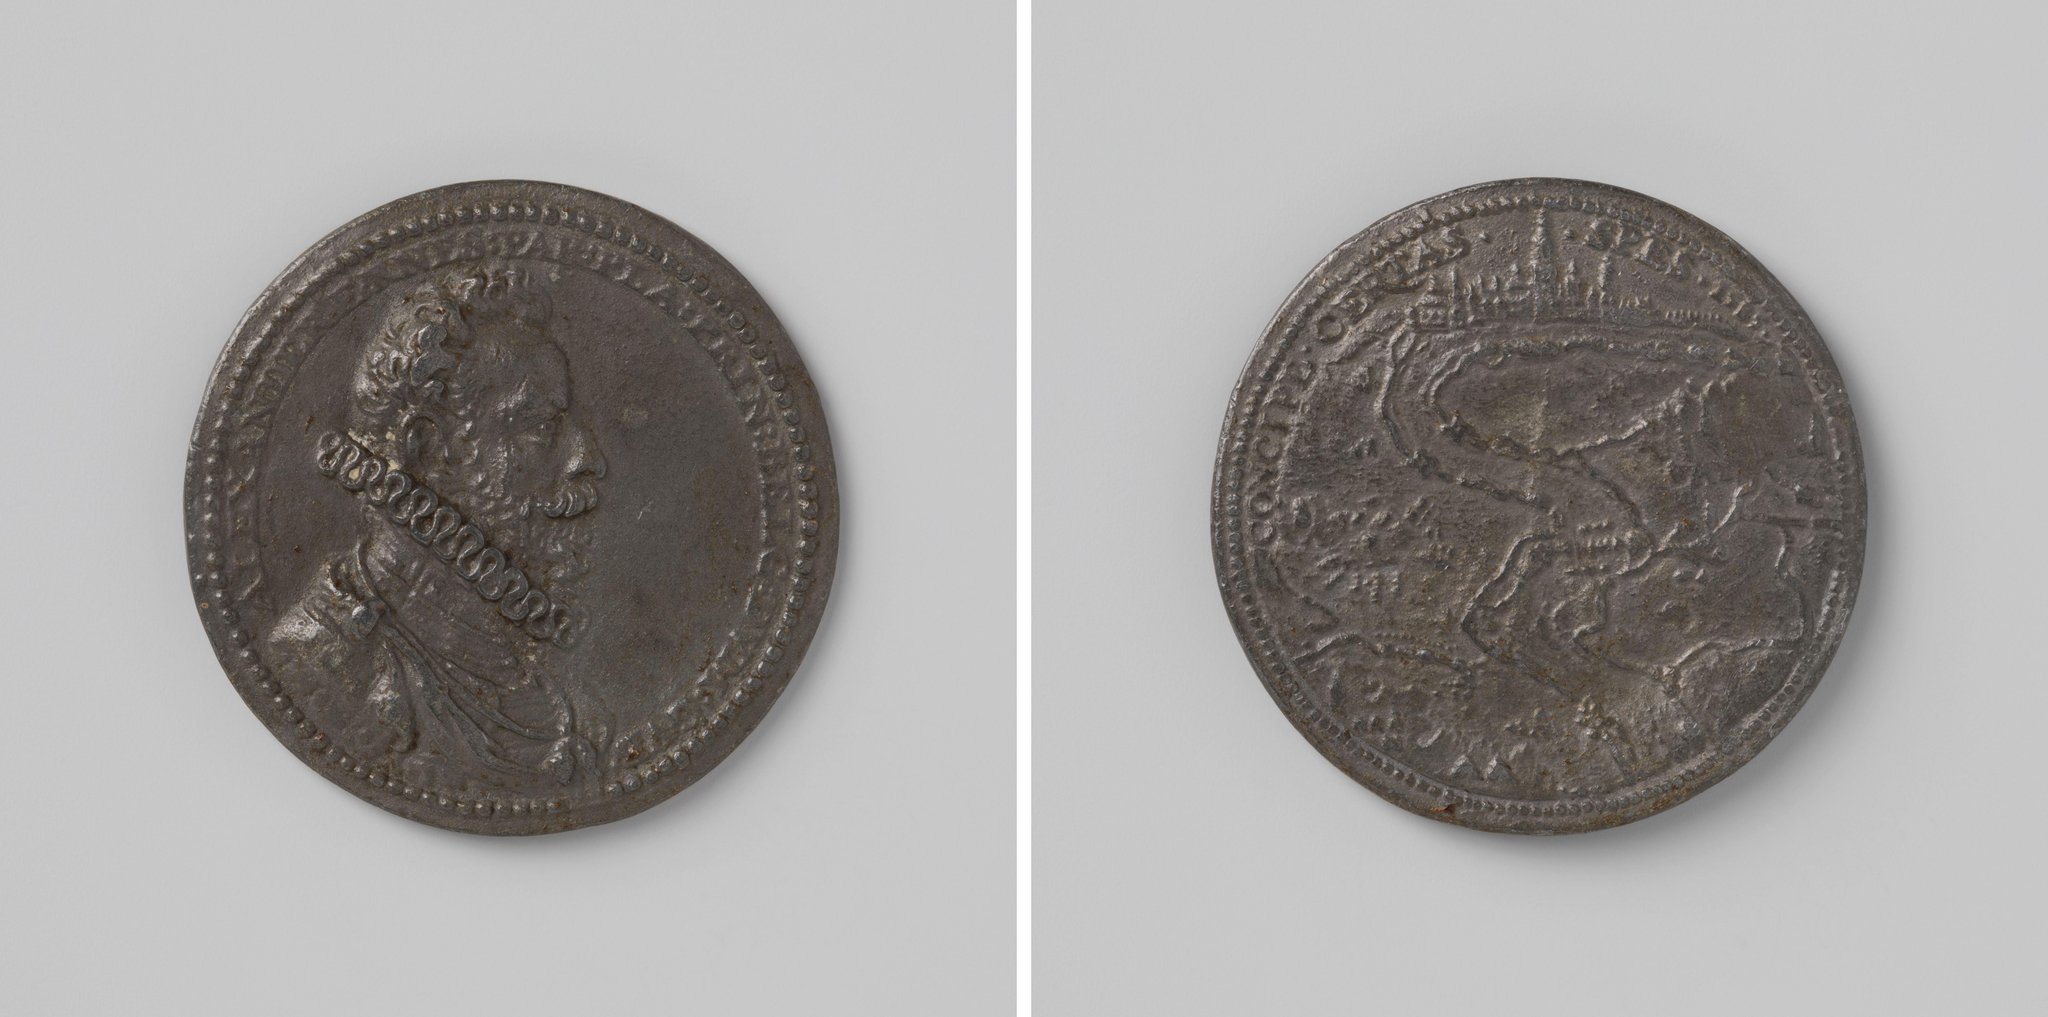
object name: history medal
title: Beleg en inname van Antwerpen door de hertog van Parma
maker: jacques jonghelinck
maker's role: medailleur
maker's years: 1530-1606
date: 1586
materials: tin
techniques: striking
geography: antwerp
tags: vienna, albert casimir van saksen-teschen, rome, alessandro farnese (landvoogd van de nederlanden en hertog van parma en piacenza), antwerp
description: Tinnen penning. Voorzijde: borststuk man binnen omschrift. Keerzijde: gezicht op stad Antwerpen, belegeringswerken, het onder water gezette land en de schipbrug binnen omschrift